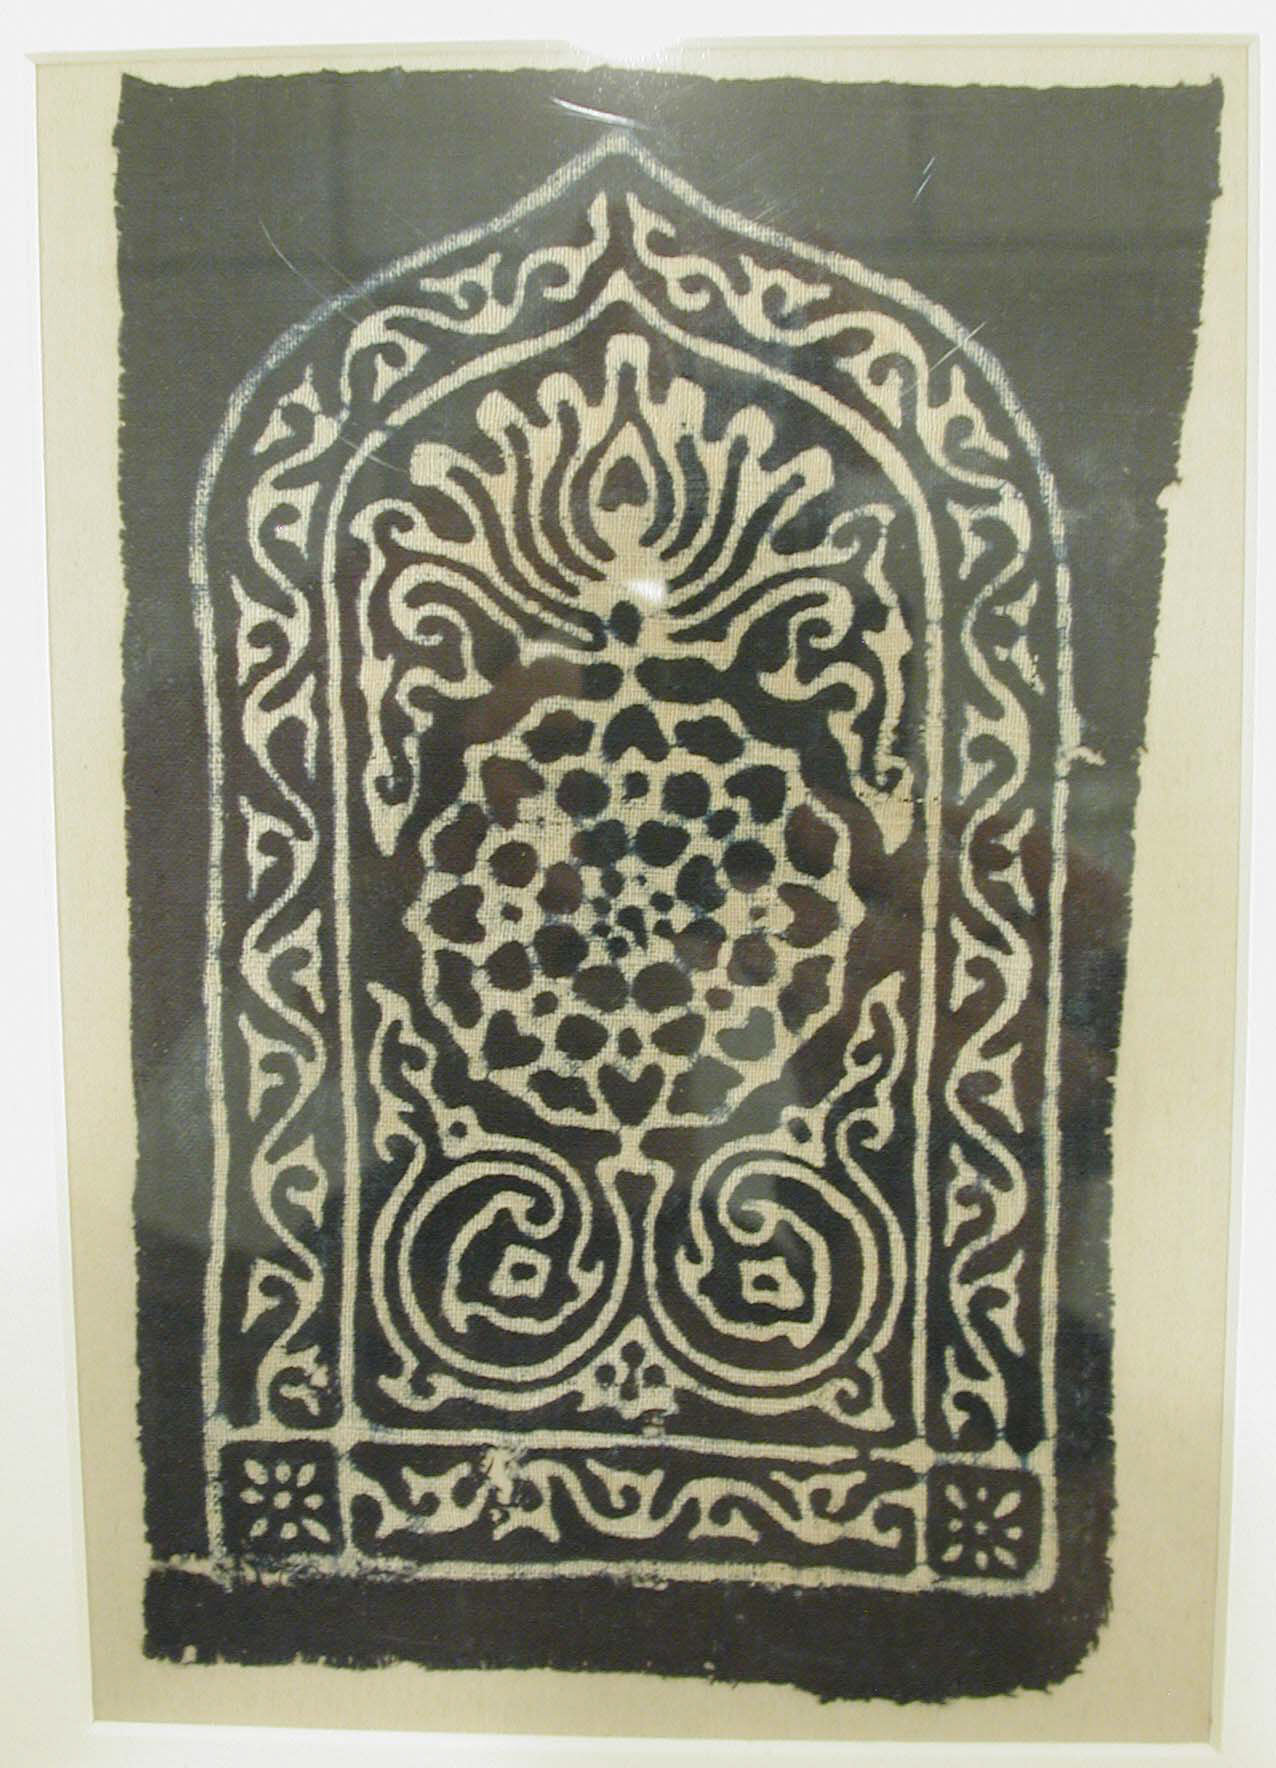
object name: textile fragment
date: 1401-1600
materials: cotton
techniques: dyeing, printing, resist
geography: india